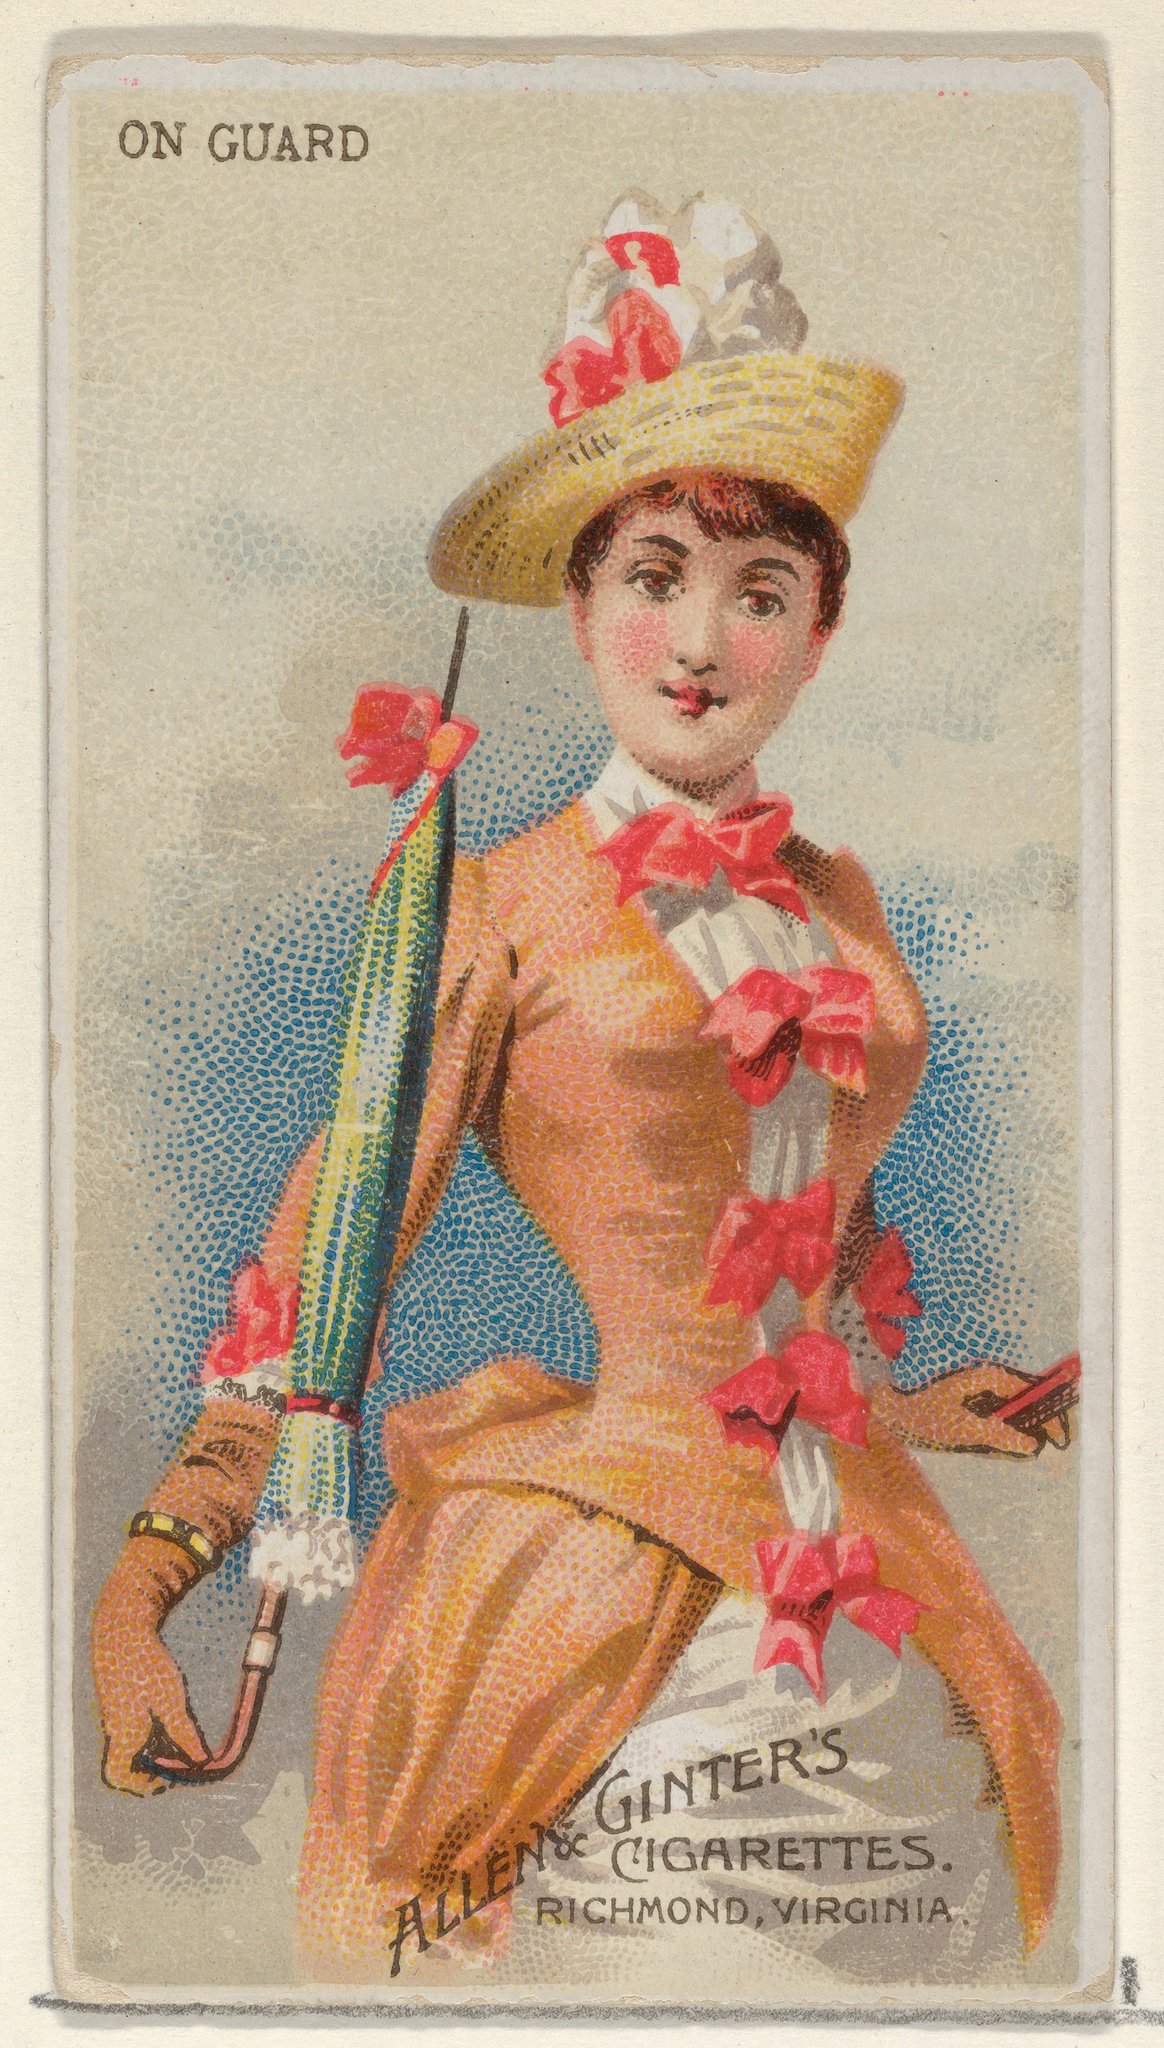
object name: print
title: On Guard, from the Parasol Drills series (N18) for Allen & Ginter Cigarettes Brands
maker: allen & ginter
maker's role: publisher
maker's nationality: american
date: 1888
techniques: color lithograph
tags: women